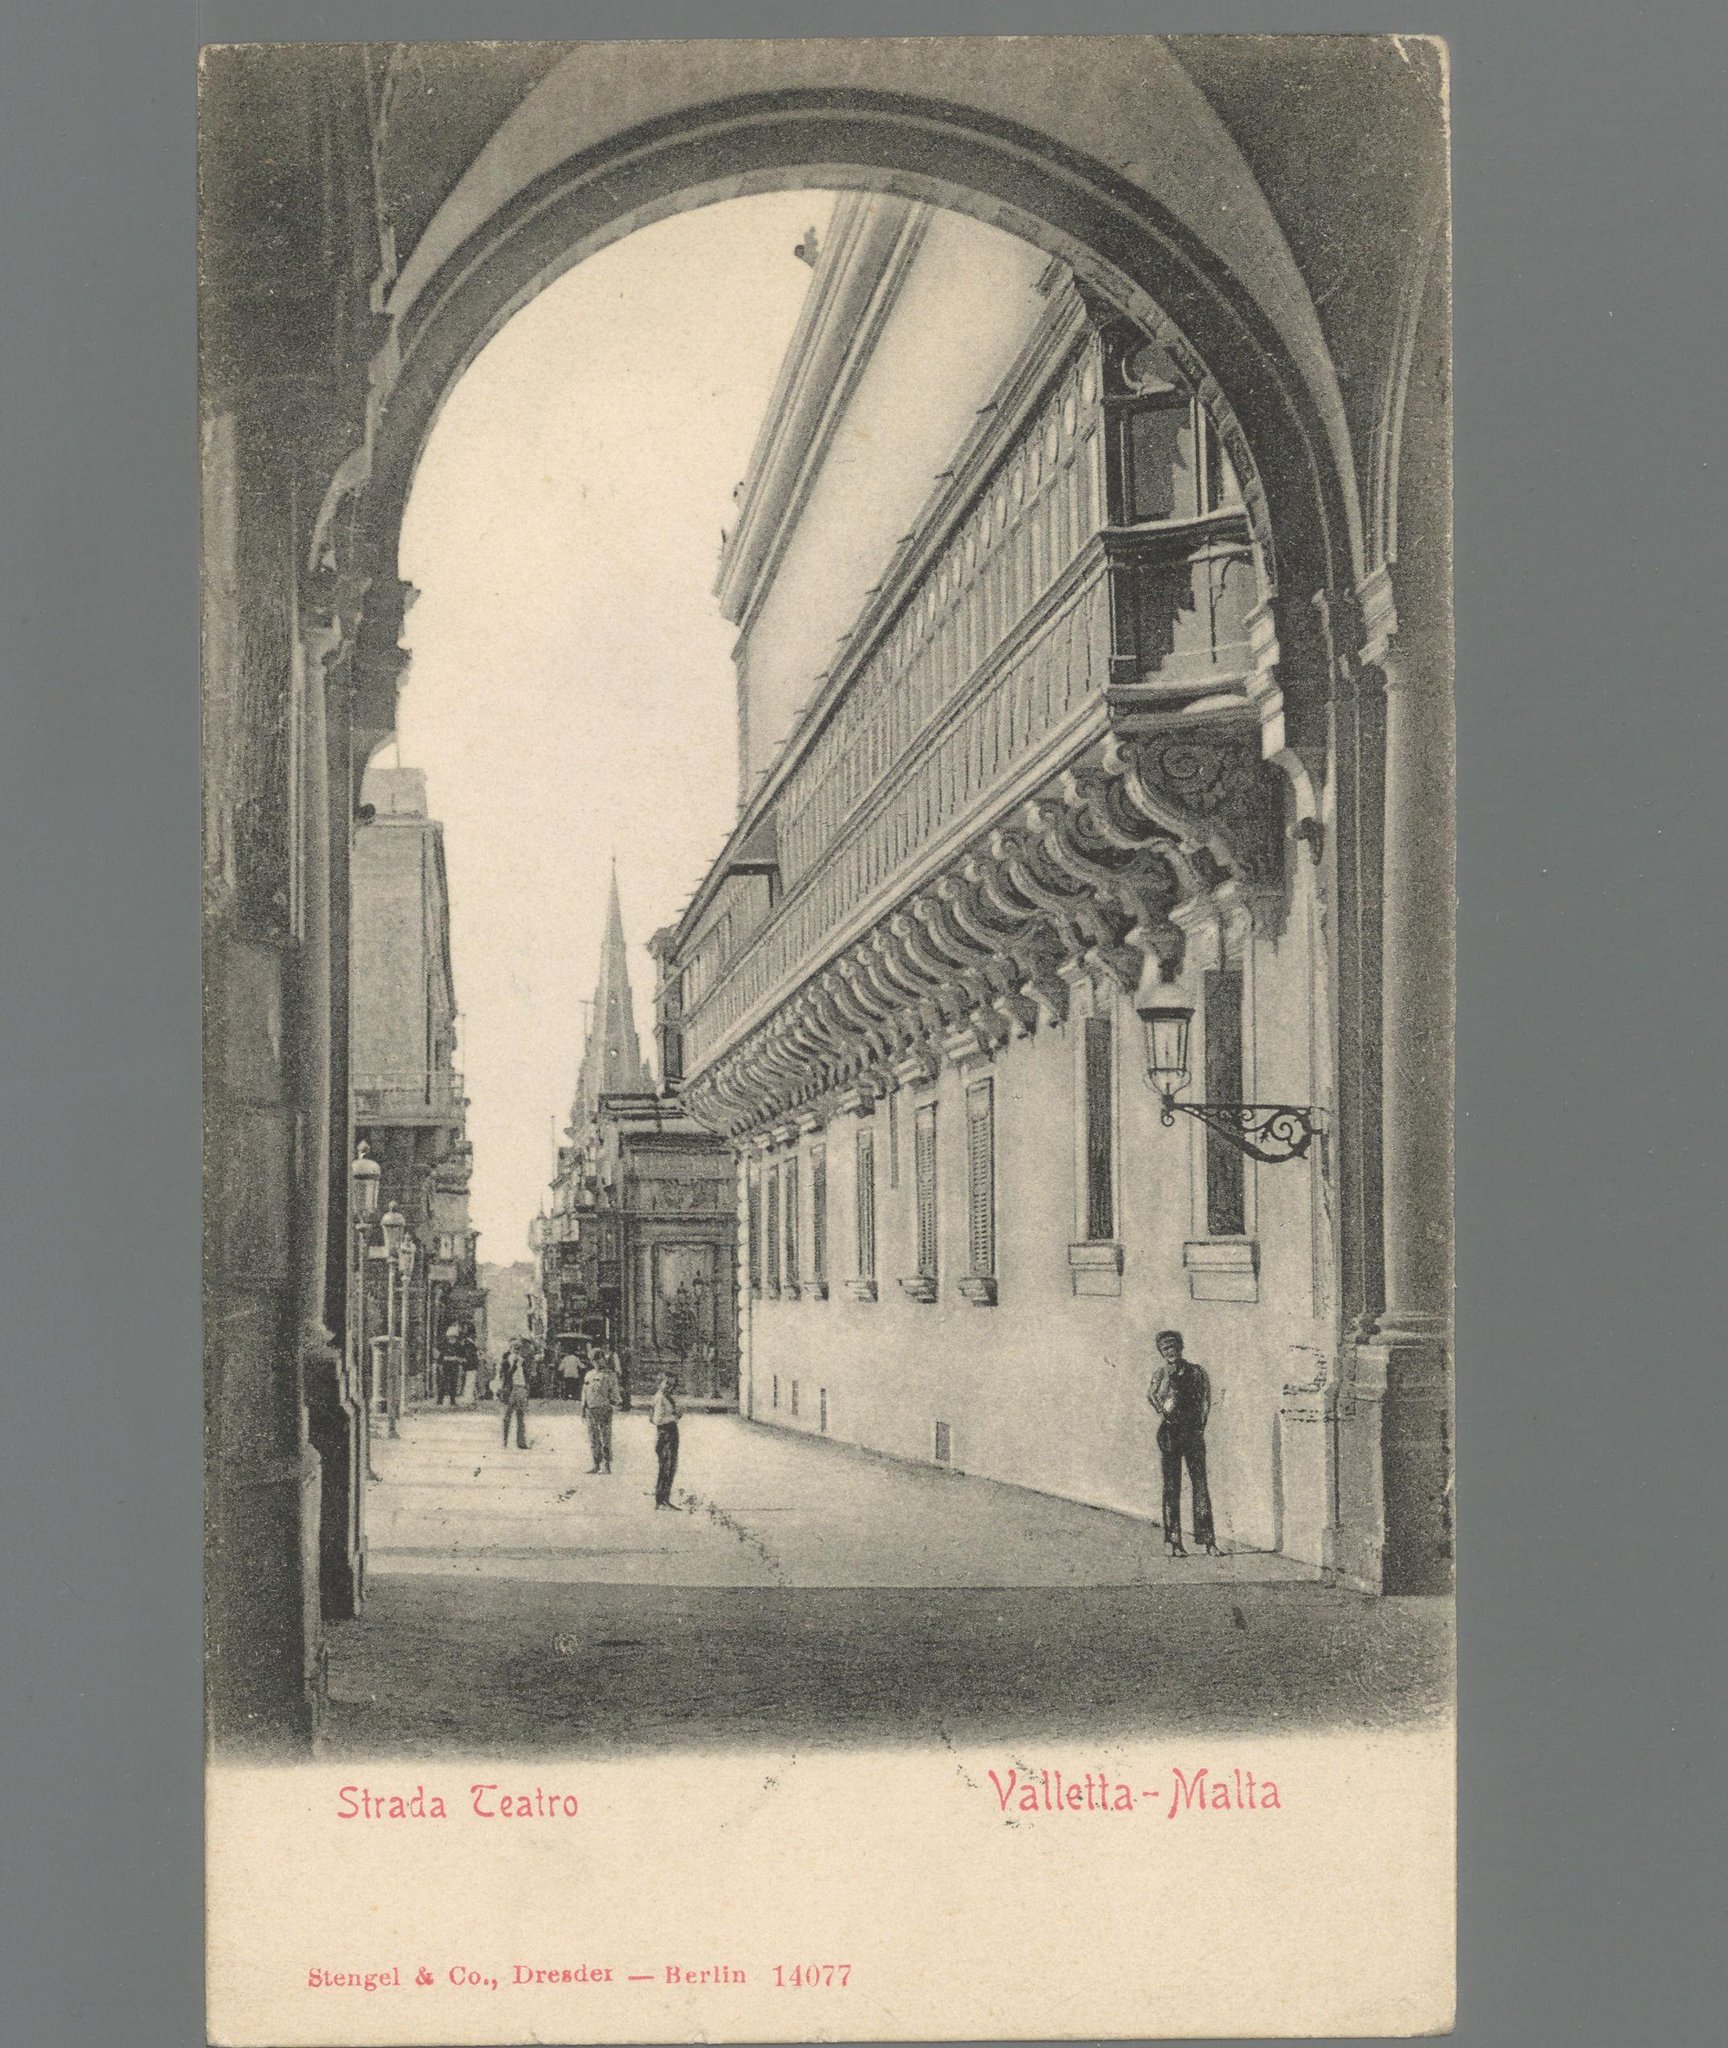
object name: ansichtkaart, prentbriefkaart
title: Strada Teatro. Valletta-Malta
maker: Anonymous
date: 1889-1903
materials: cardboard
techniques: photograph, writing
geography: dresden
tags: street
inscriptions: poststempel, verso, gestempeld